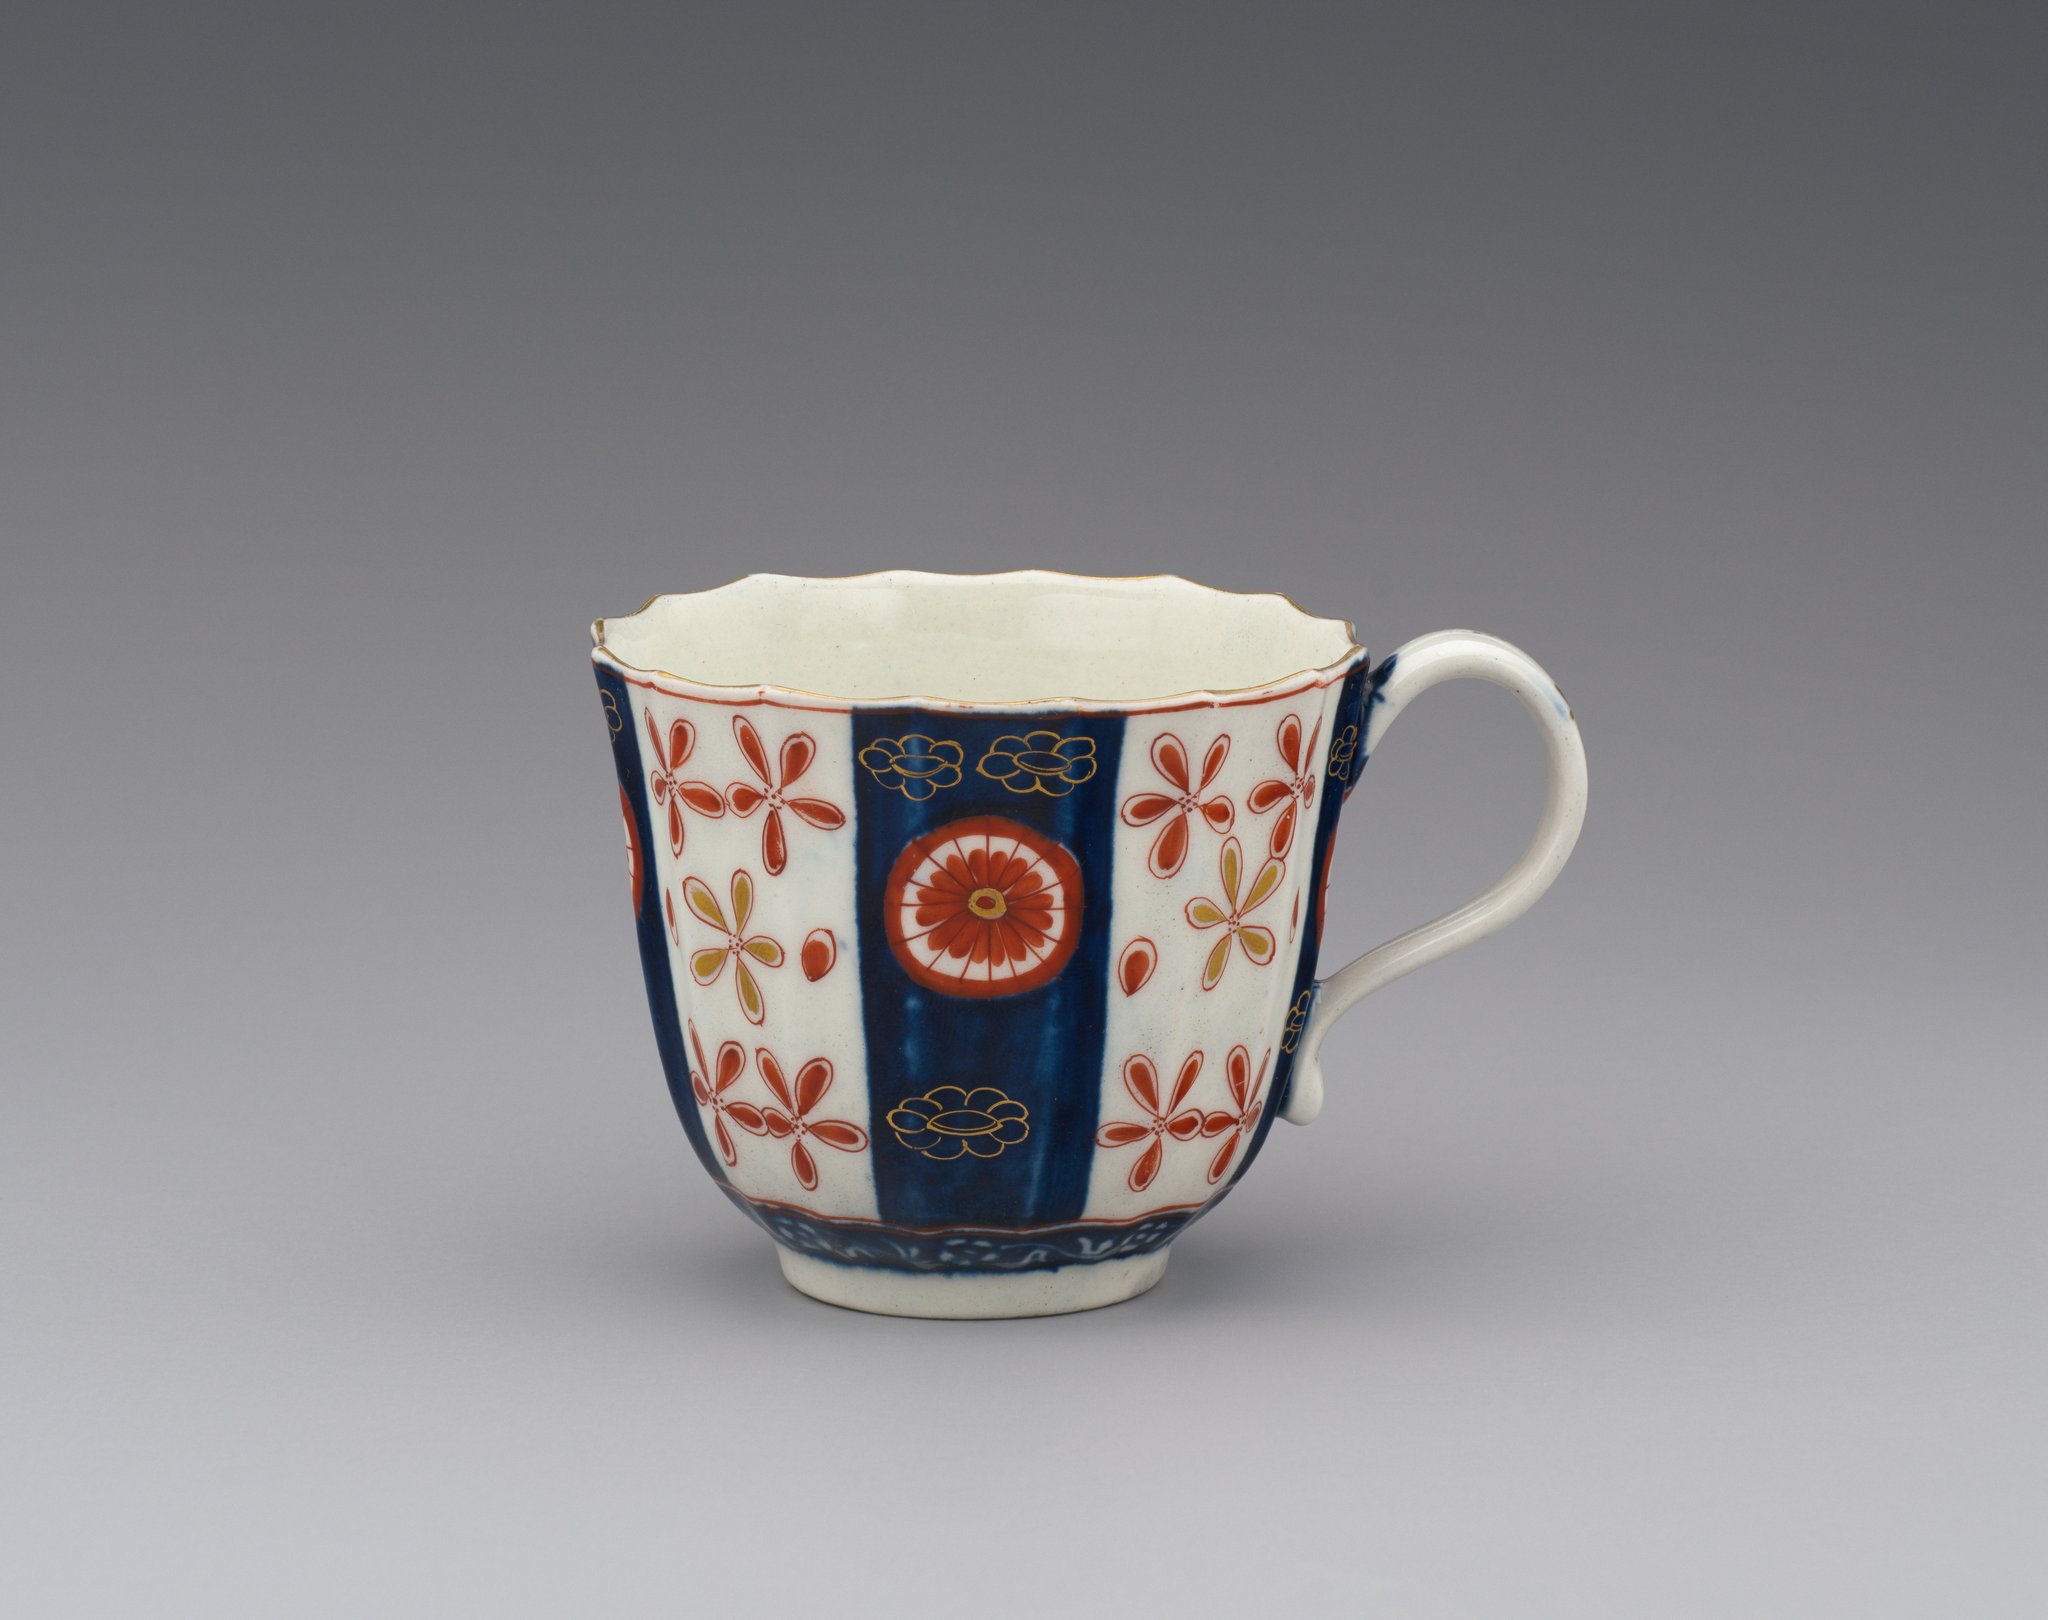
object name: chocolate cup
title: Chocolate cup (part of a service)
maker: worcester factory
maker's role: factory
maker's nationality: british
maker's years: 1751-2008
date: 1765-1775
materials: soft paste porcelain